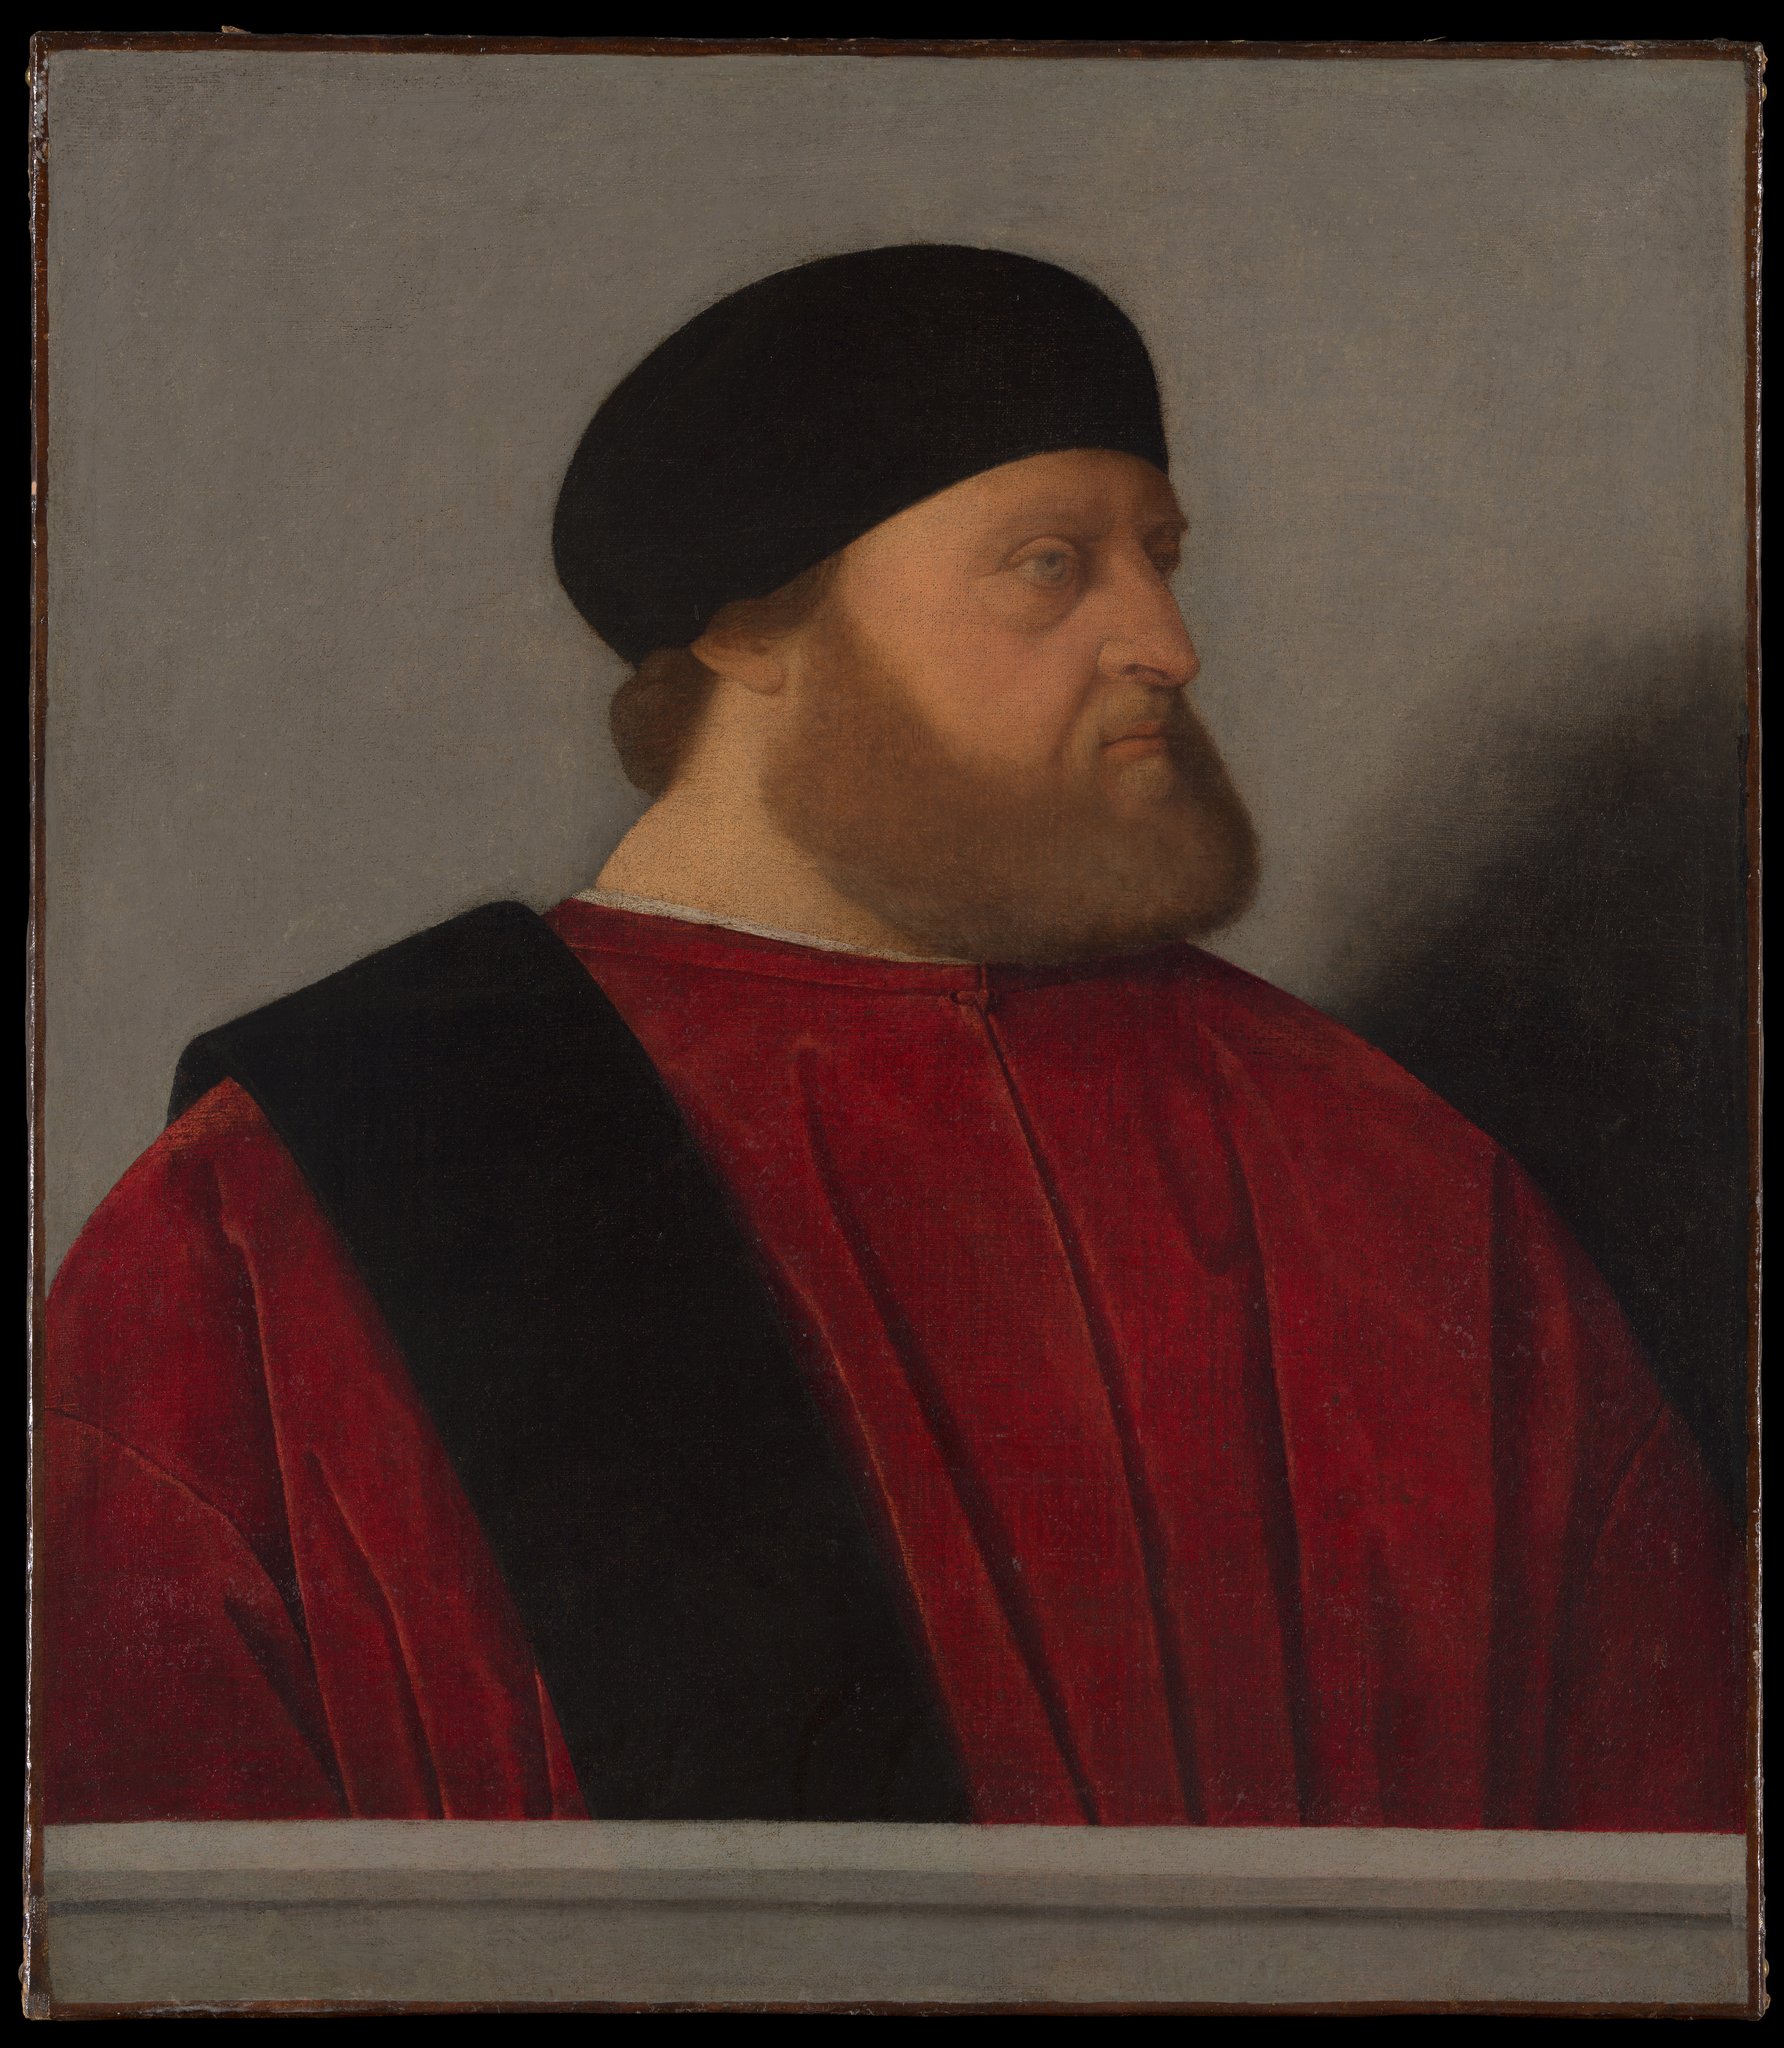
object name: painting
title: Portrait of a Venetian Senator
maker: catena (vincenzo di biagio)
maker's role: artist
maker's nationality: italian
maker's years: 1506-1531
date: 1525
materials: canvas, oil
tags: men,portraits